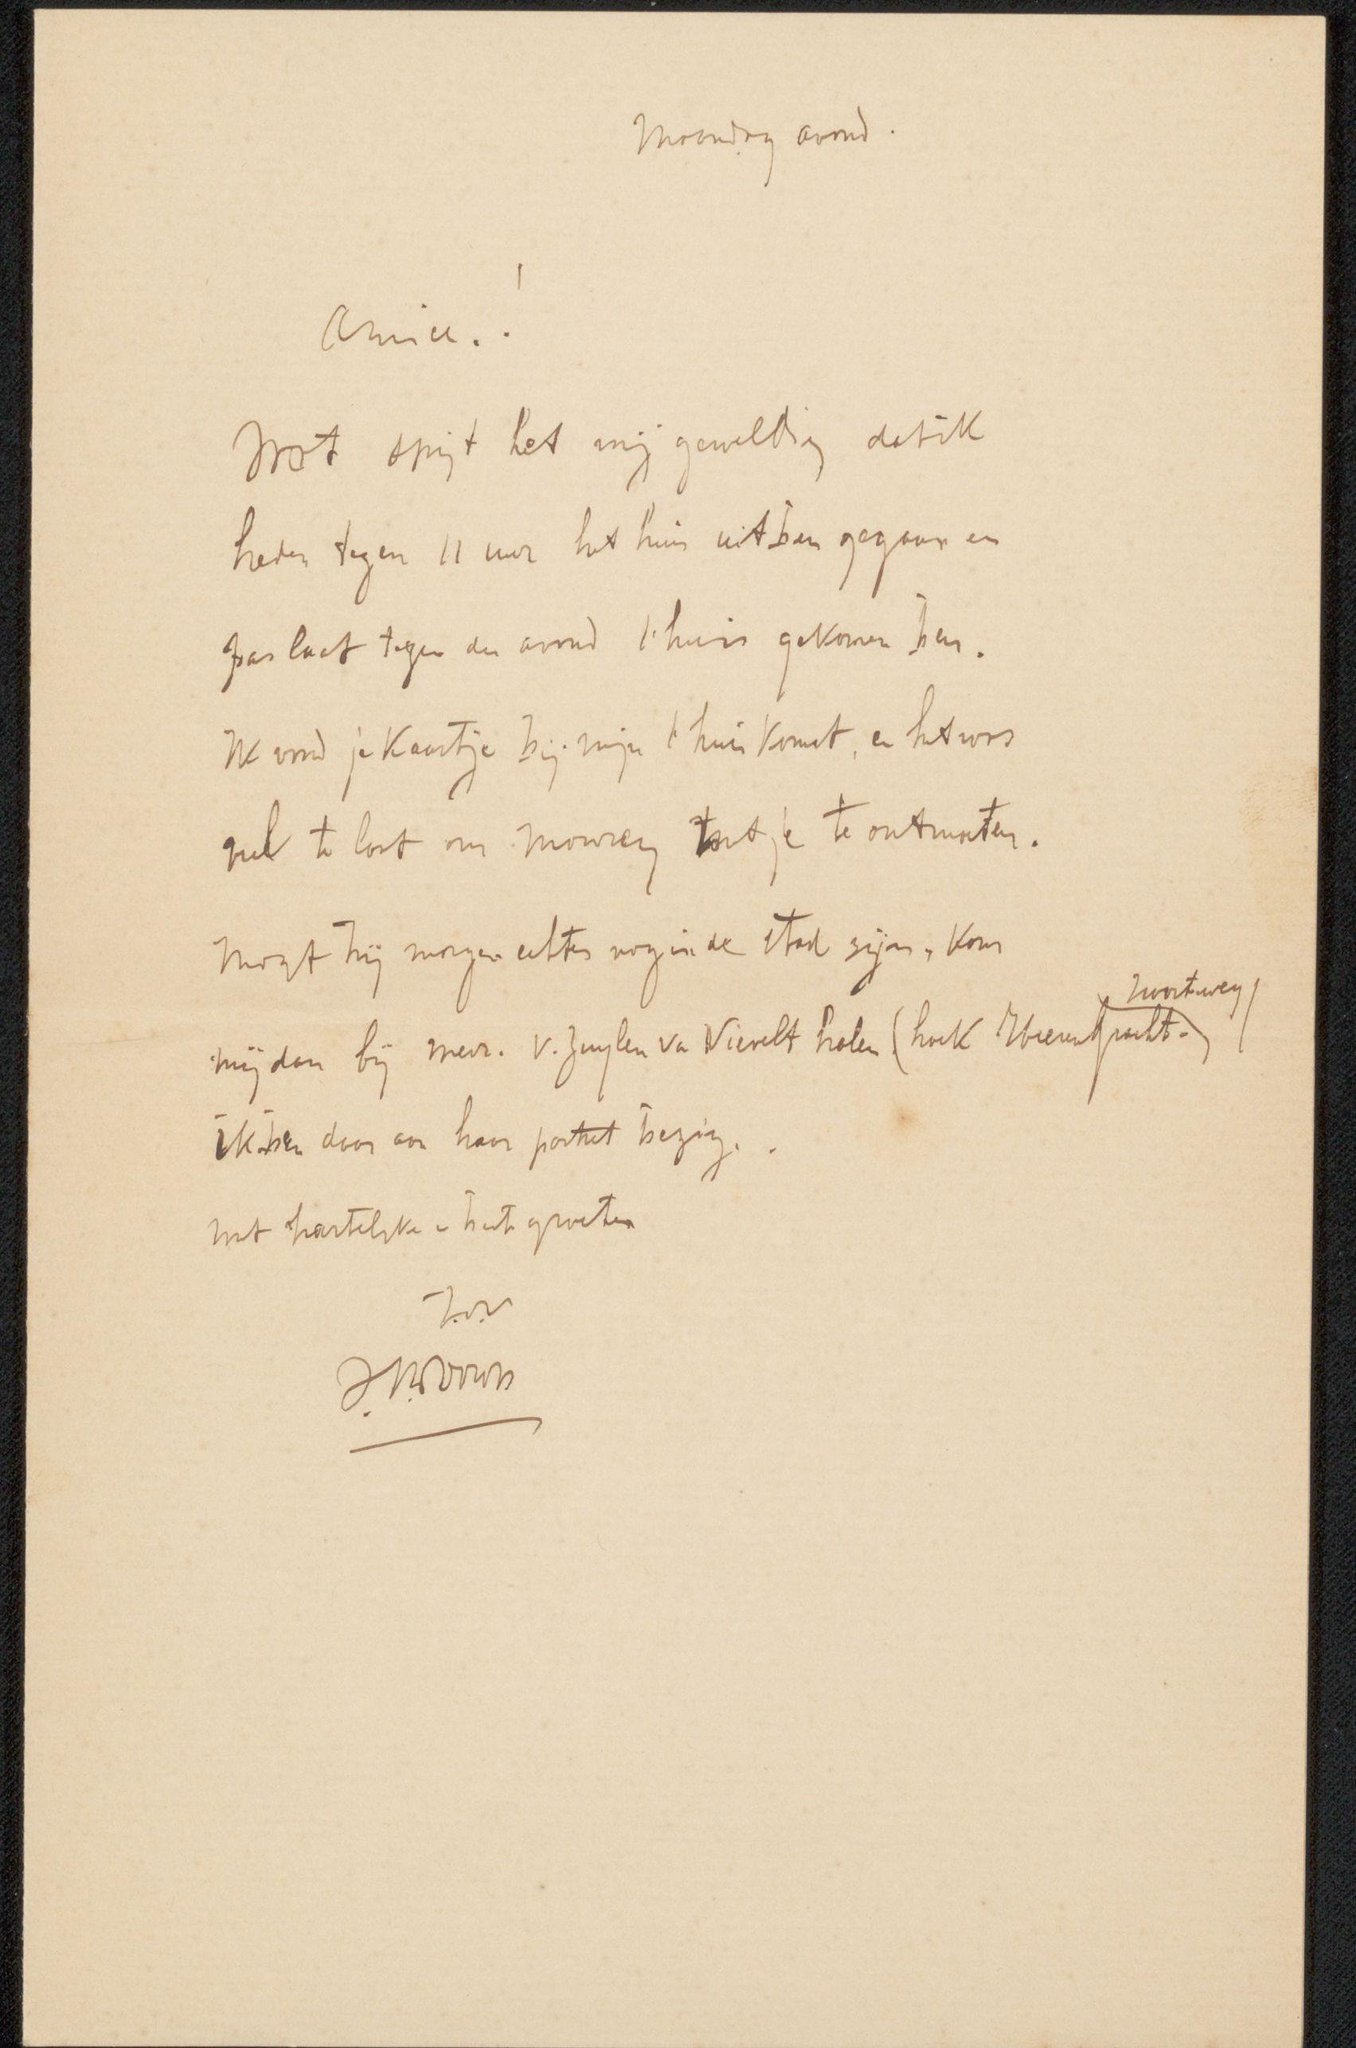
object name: letter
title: Brief aan Philip Zilcken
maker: jan toorop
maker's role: draughtsman, painter, print maker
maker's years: 1858-1928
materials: ink, paper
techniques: pen, writing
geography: the hague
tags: marseille, gabriel mourey, draughtsman, philip zilcken, historical persons (portraits and scenes from the life)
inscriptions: collector's mark: ‘RPK’